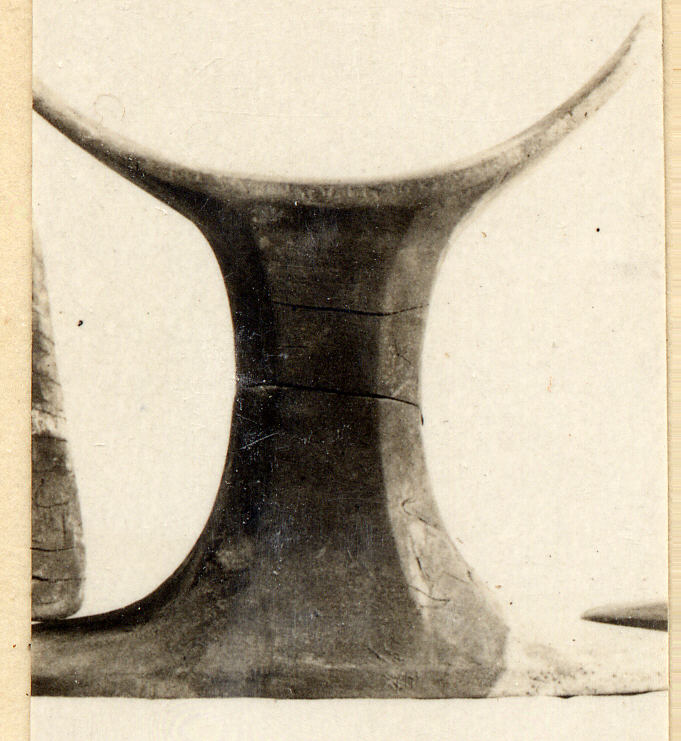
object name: headrest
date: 2030-1504 BCE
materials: wood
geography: egypt